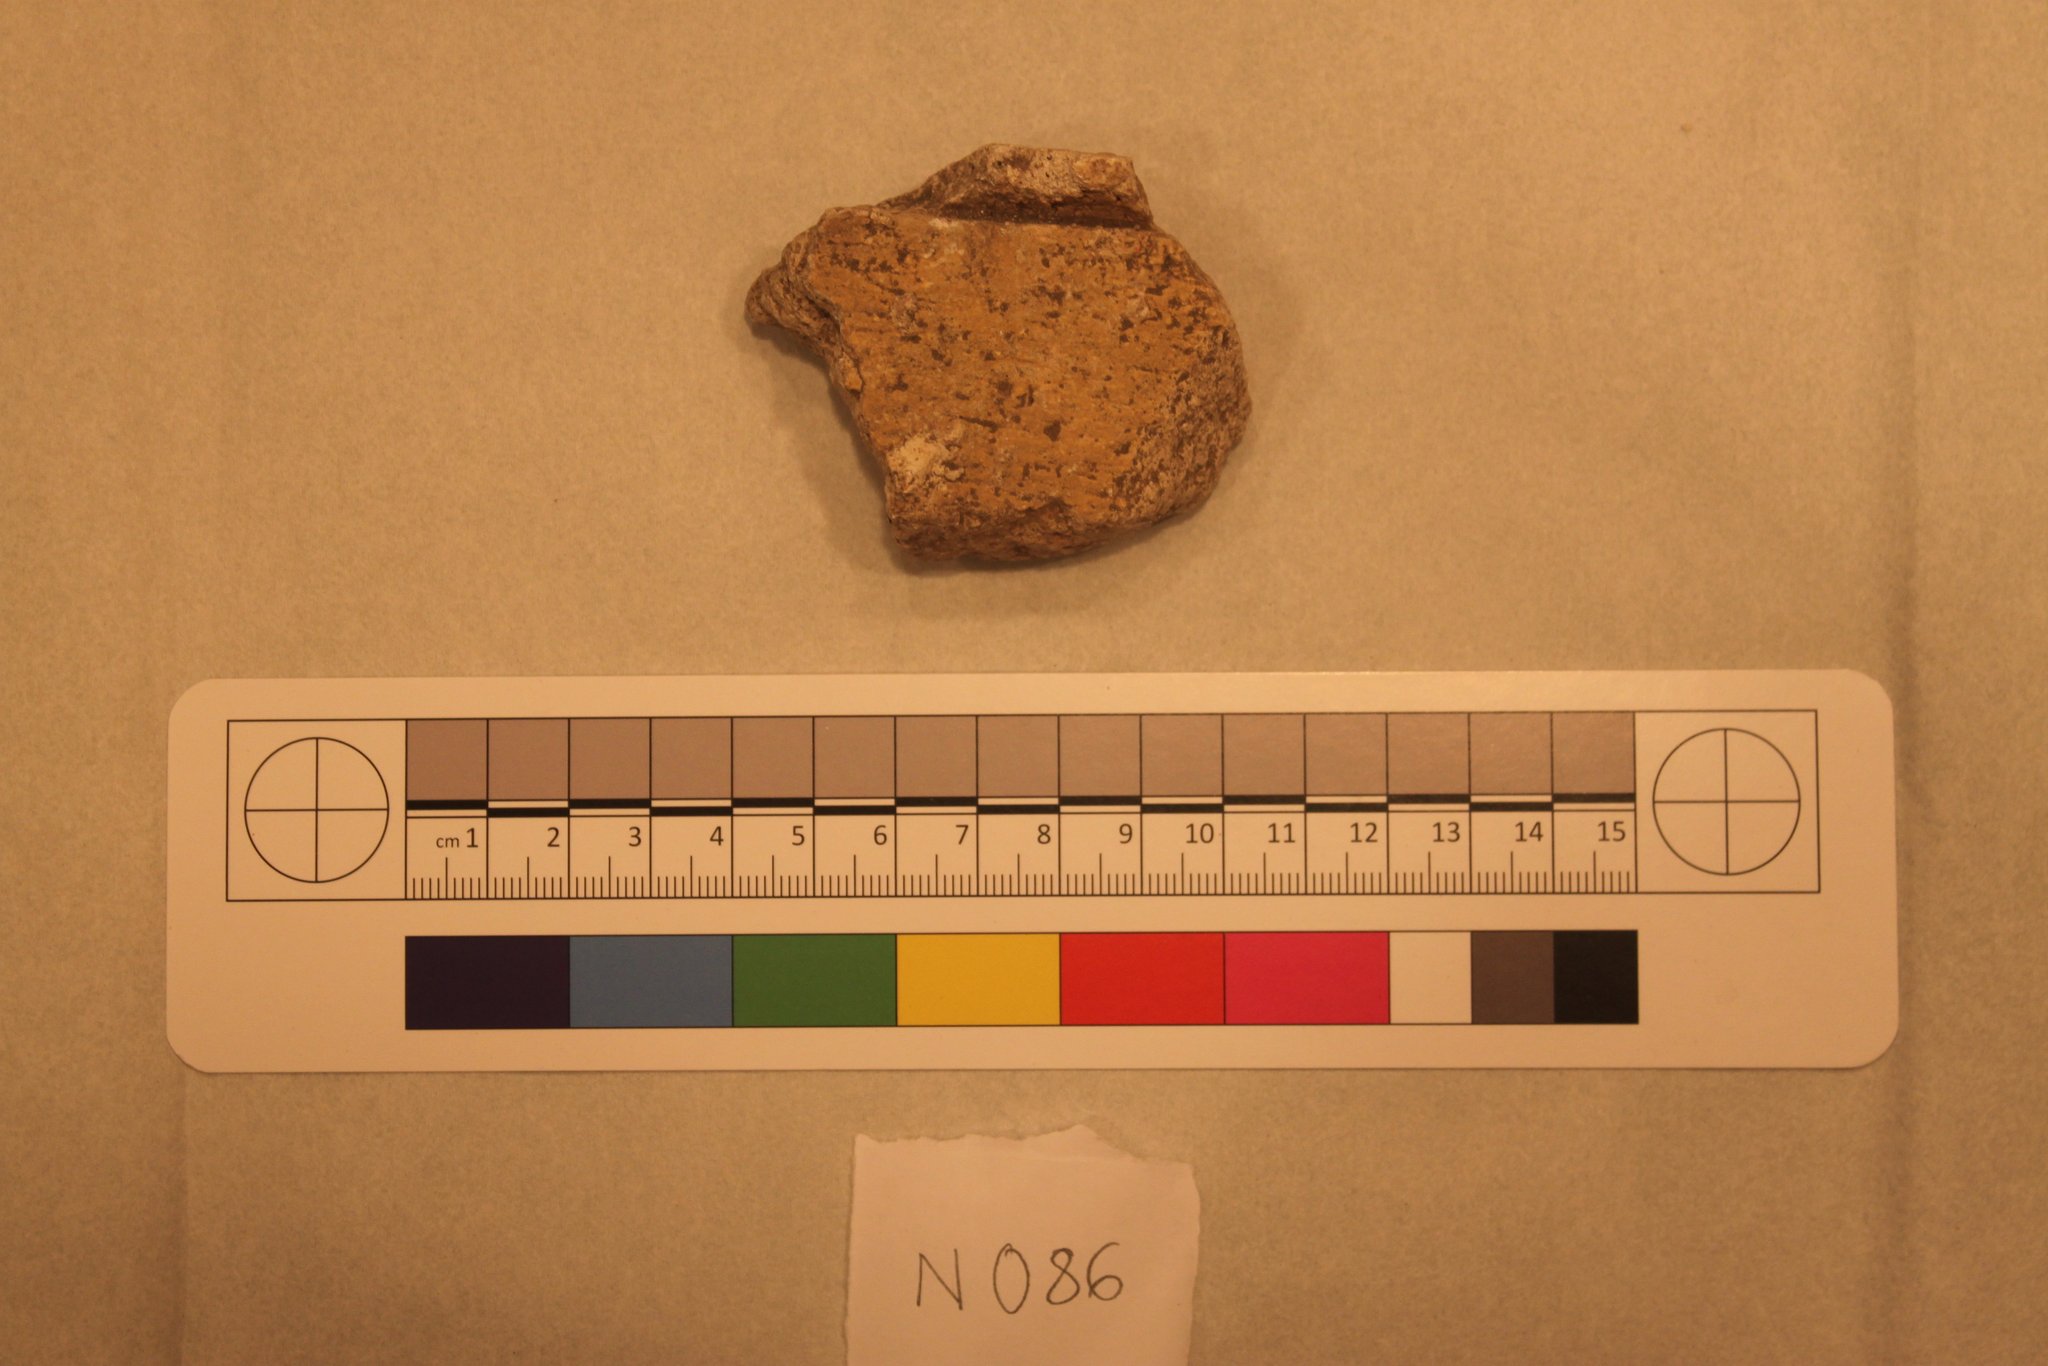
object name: fragment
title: Stucco Fragment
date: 701-1200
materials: plaster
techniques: carving, painting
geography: iran